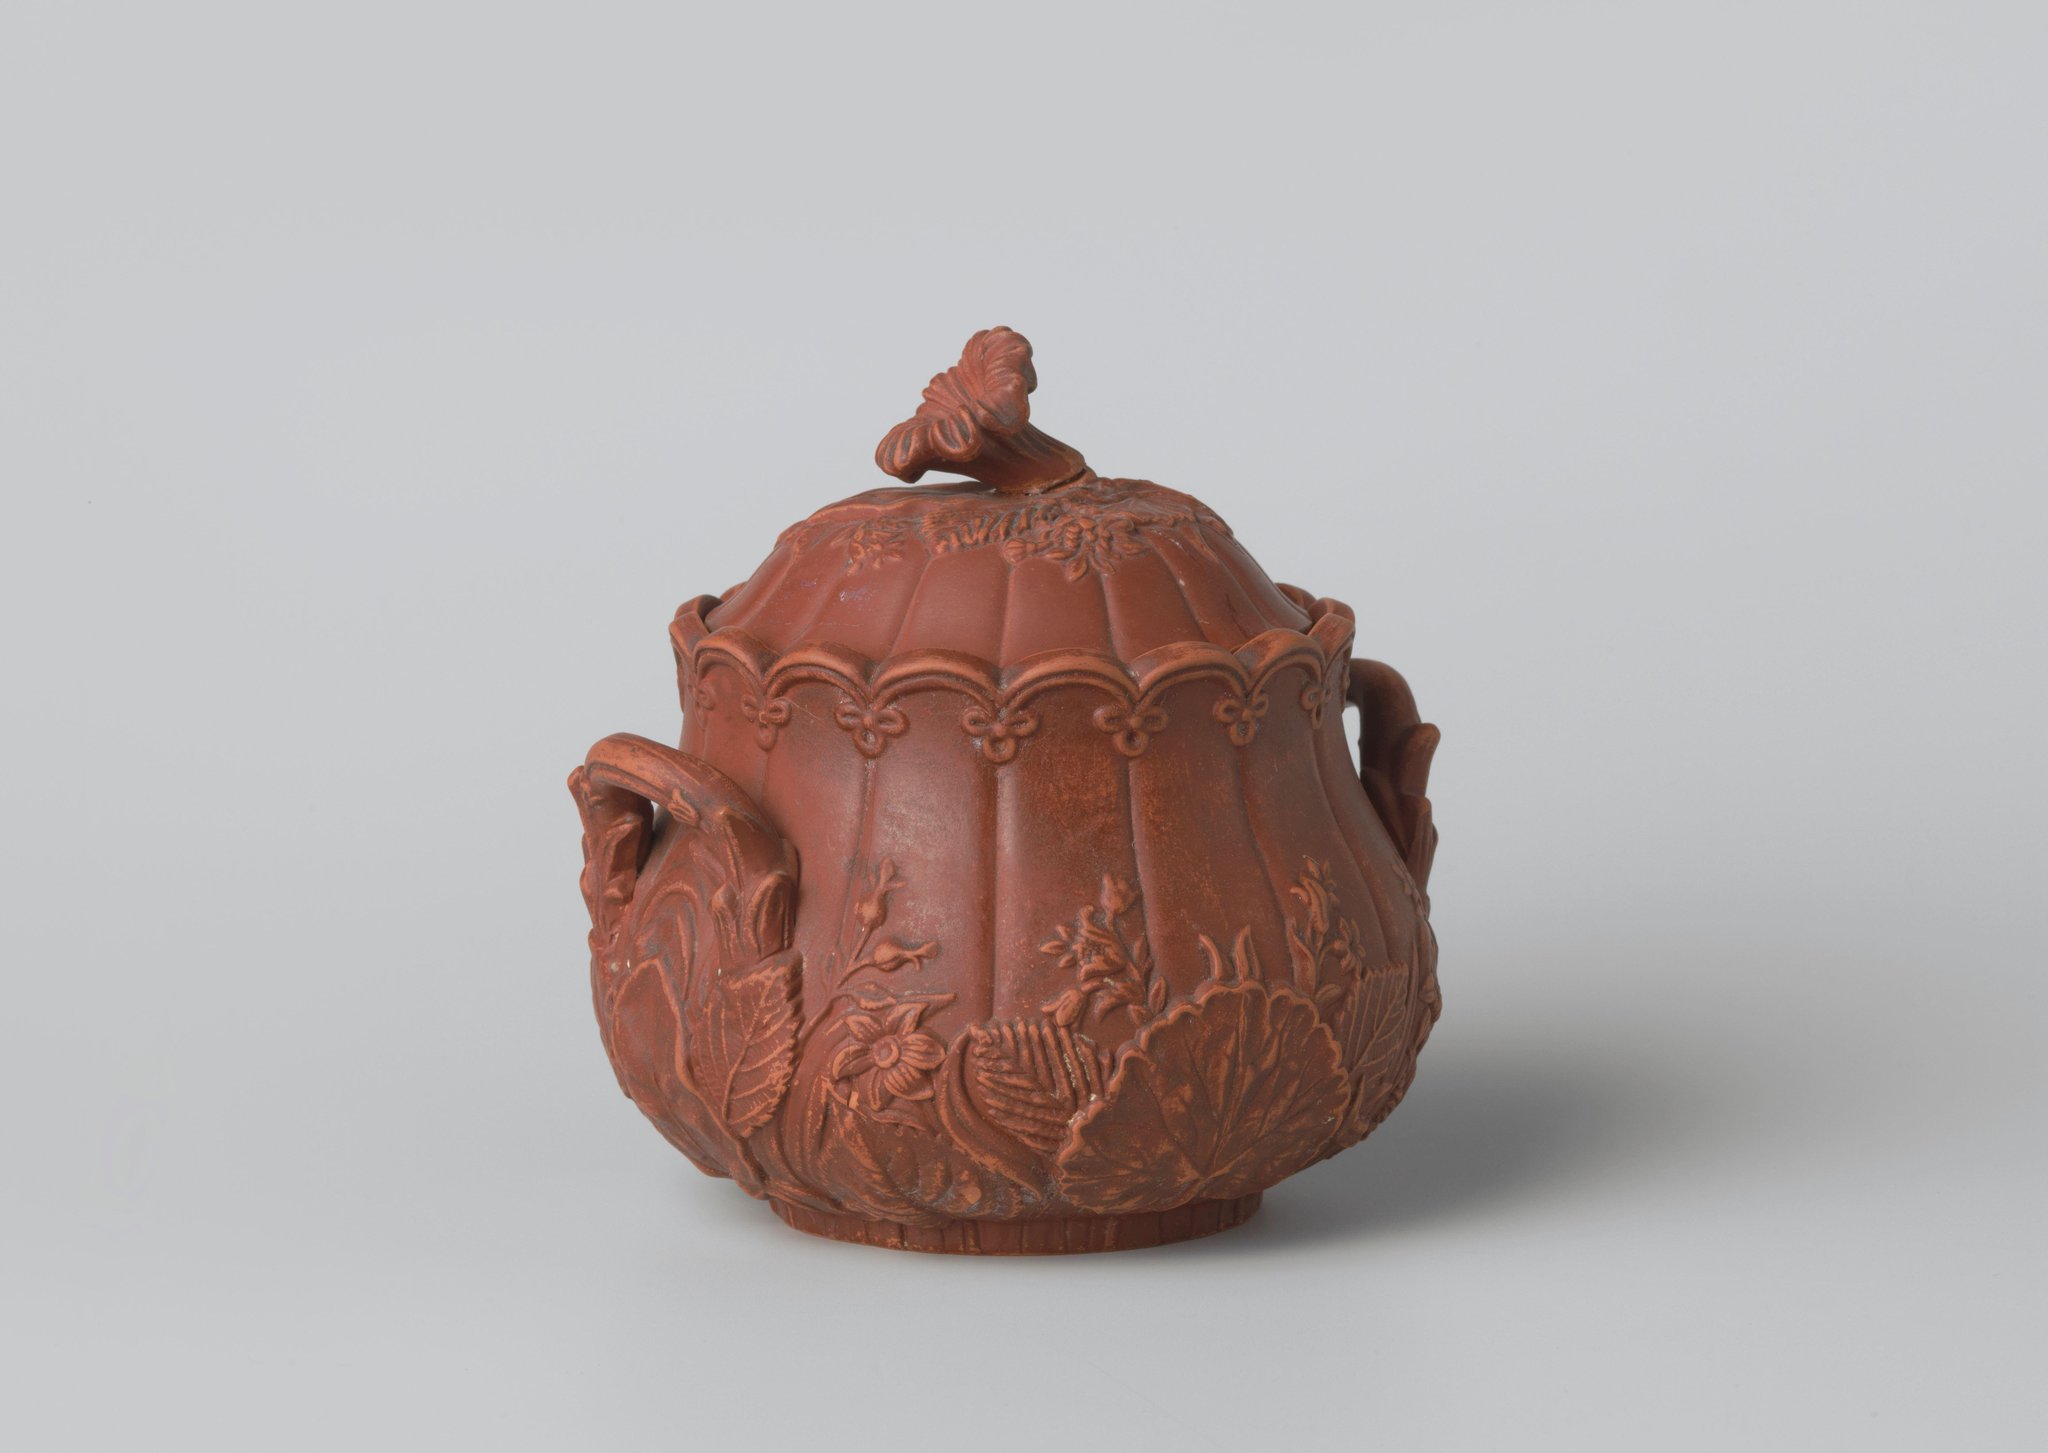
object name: lid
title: Deksel, geschulpt, met bloemen en bladeren in reliëf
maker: Anonymous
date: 1400-1950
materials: terracotta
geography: germany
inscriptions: check stamp: ‘WS & Ss 72’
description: Deksel van terracotta. Het geschulpte lichaam met bloemen en bladeren in reliëf. Het gewelfde, geschulpte deksel wordt bekroond door een bloemvormige knop.